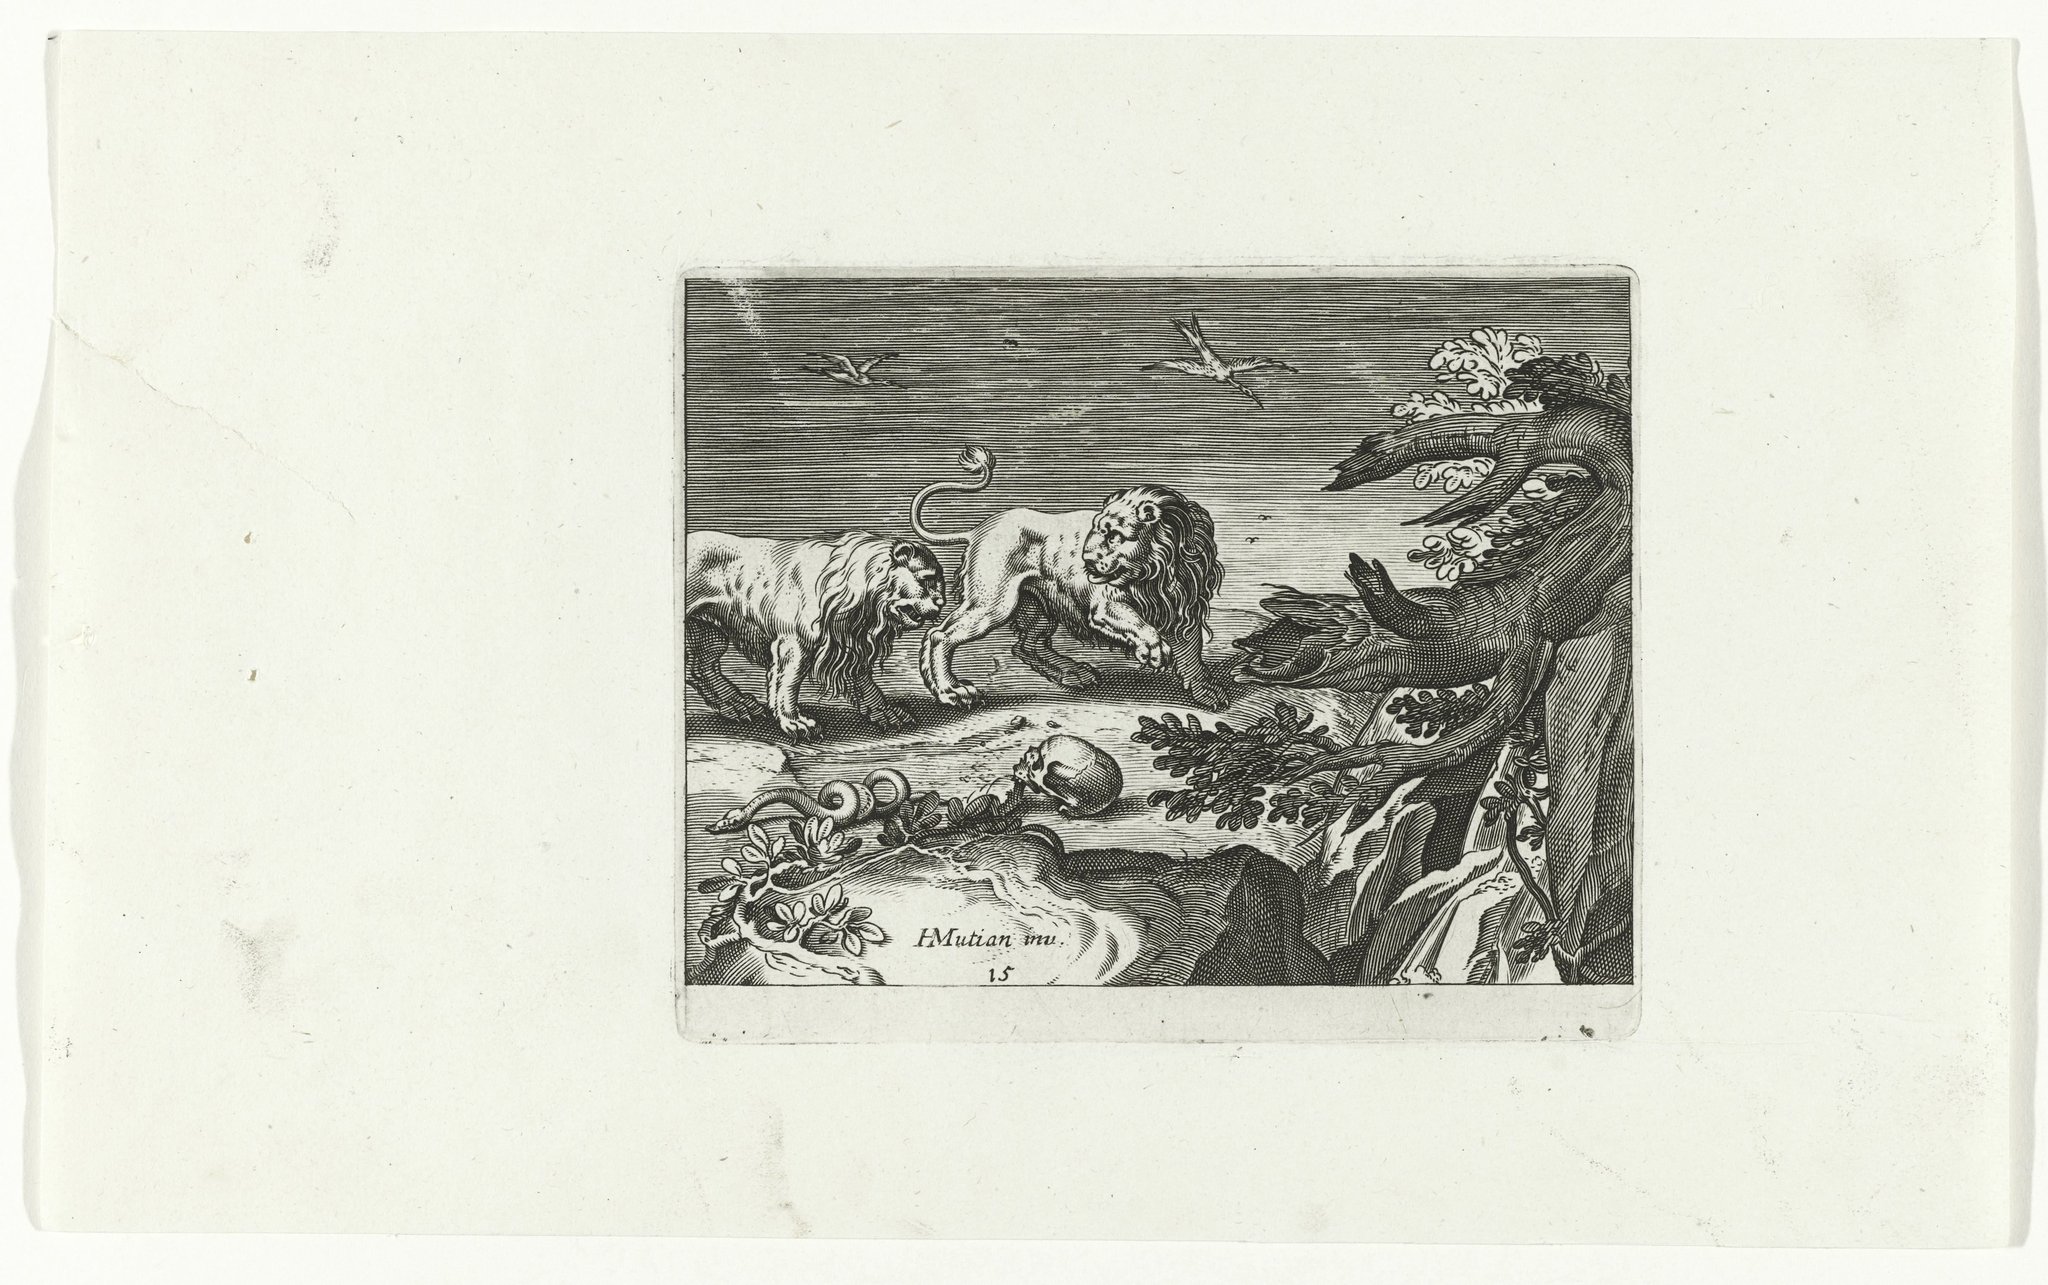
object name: print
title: Twee leeuwen, een slang en een schedel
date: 1588-1650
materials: paper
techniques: engraving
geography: netherlands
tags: snakes, (human) skull, beasts of prey, predatory animals: lion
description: De leeuwen en de stronk rechts zijn gekopieerd naar een prent van Cort naar ontwerp van Muziano. De slang is gekopieerd naar een prent van Saenredam naar ontwerp van Bloemaert.